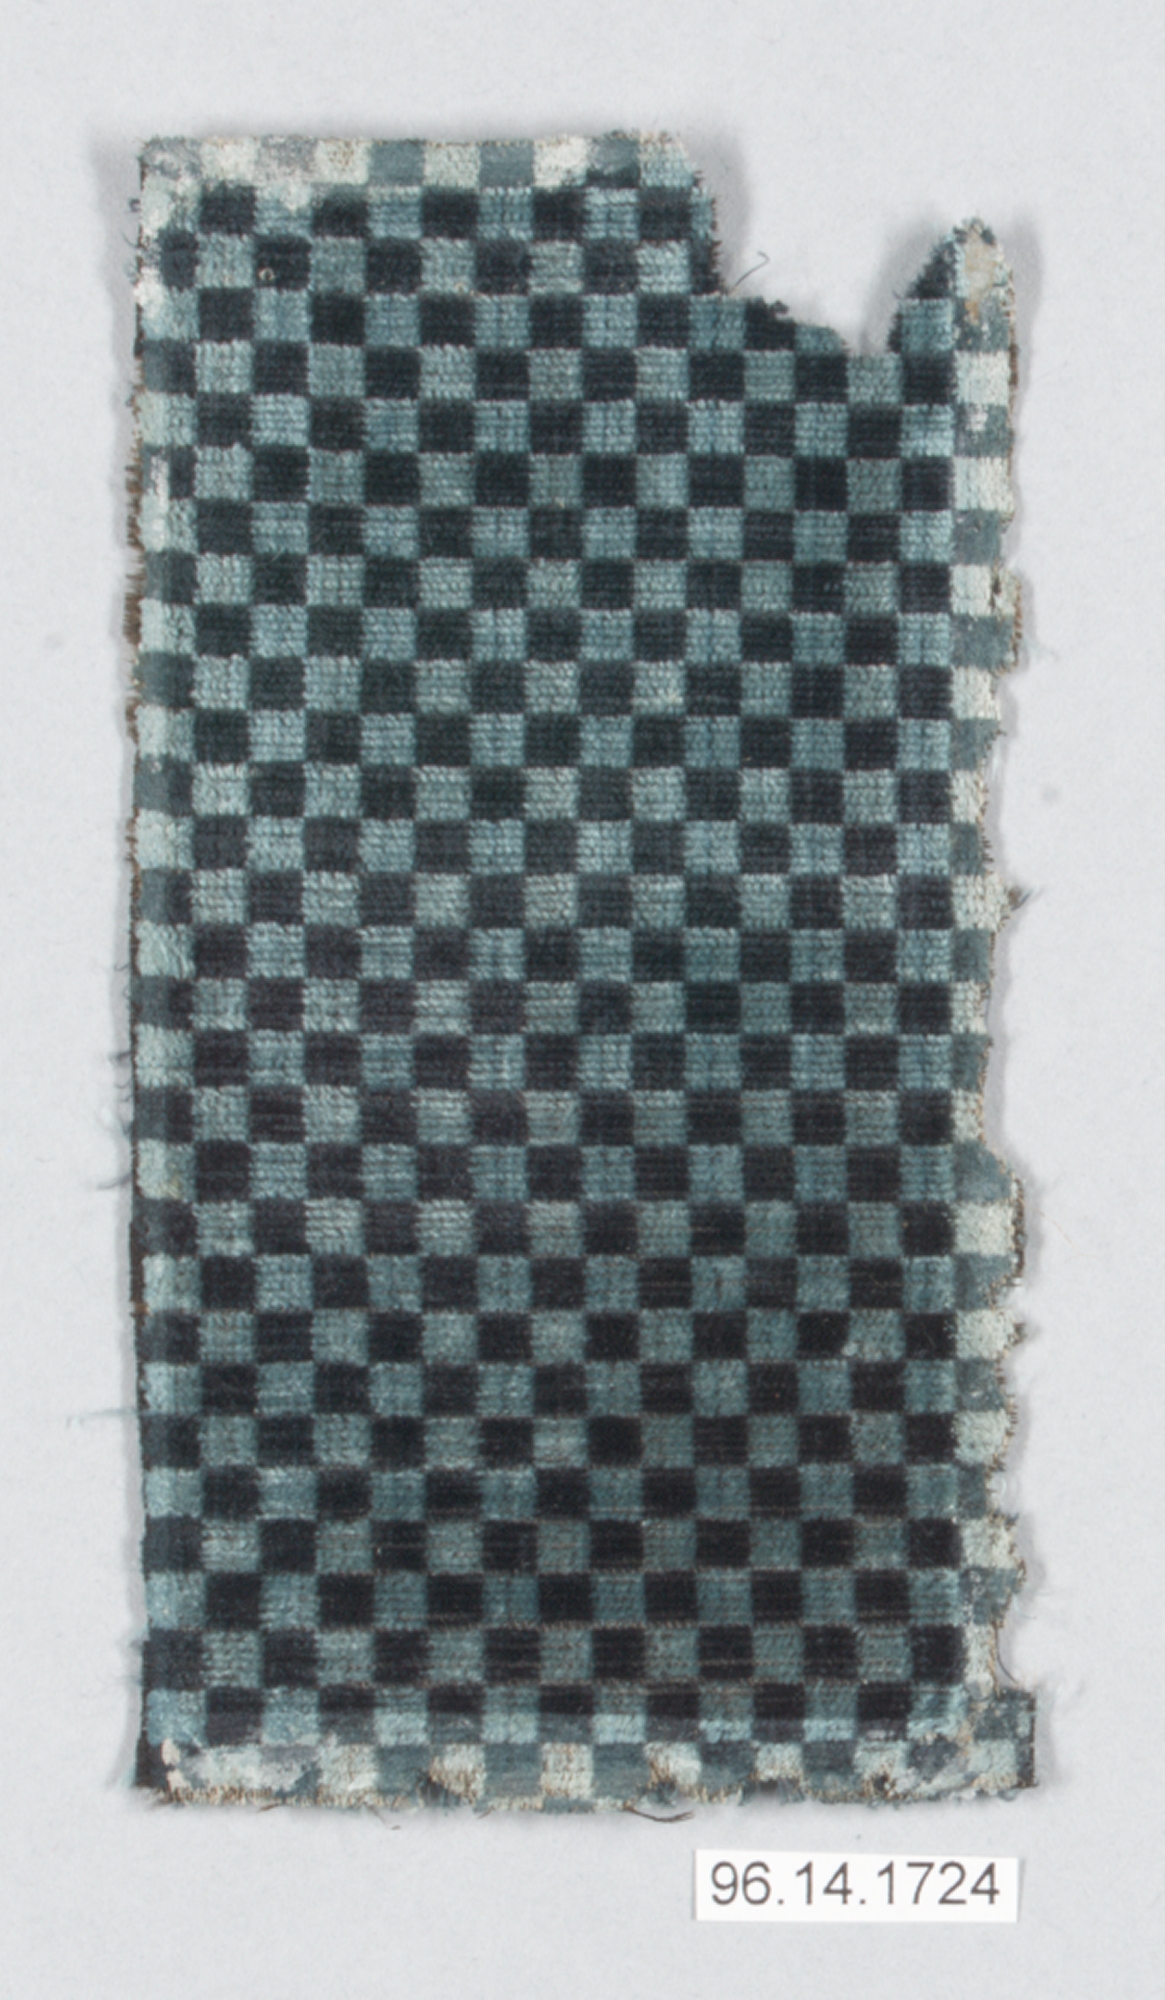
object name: piece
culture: japanese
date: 1767-1800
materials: silk